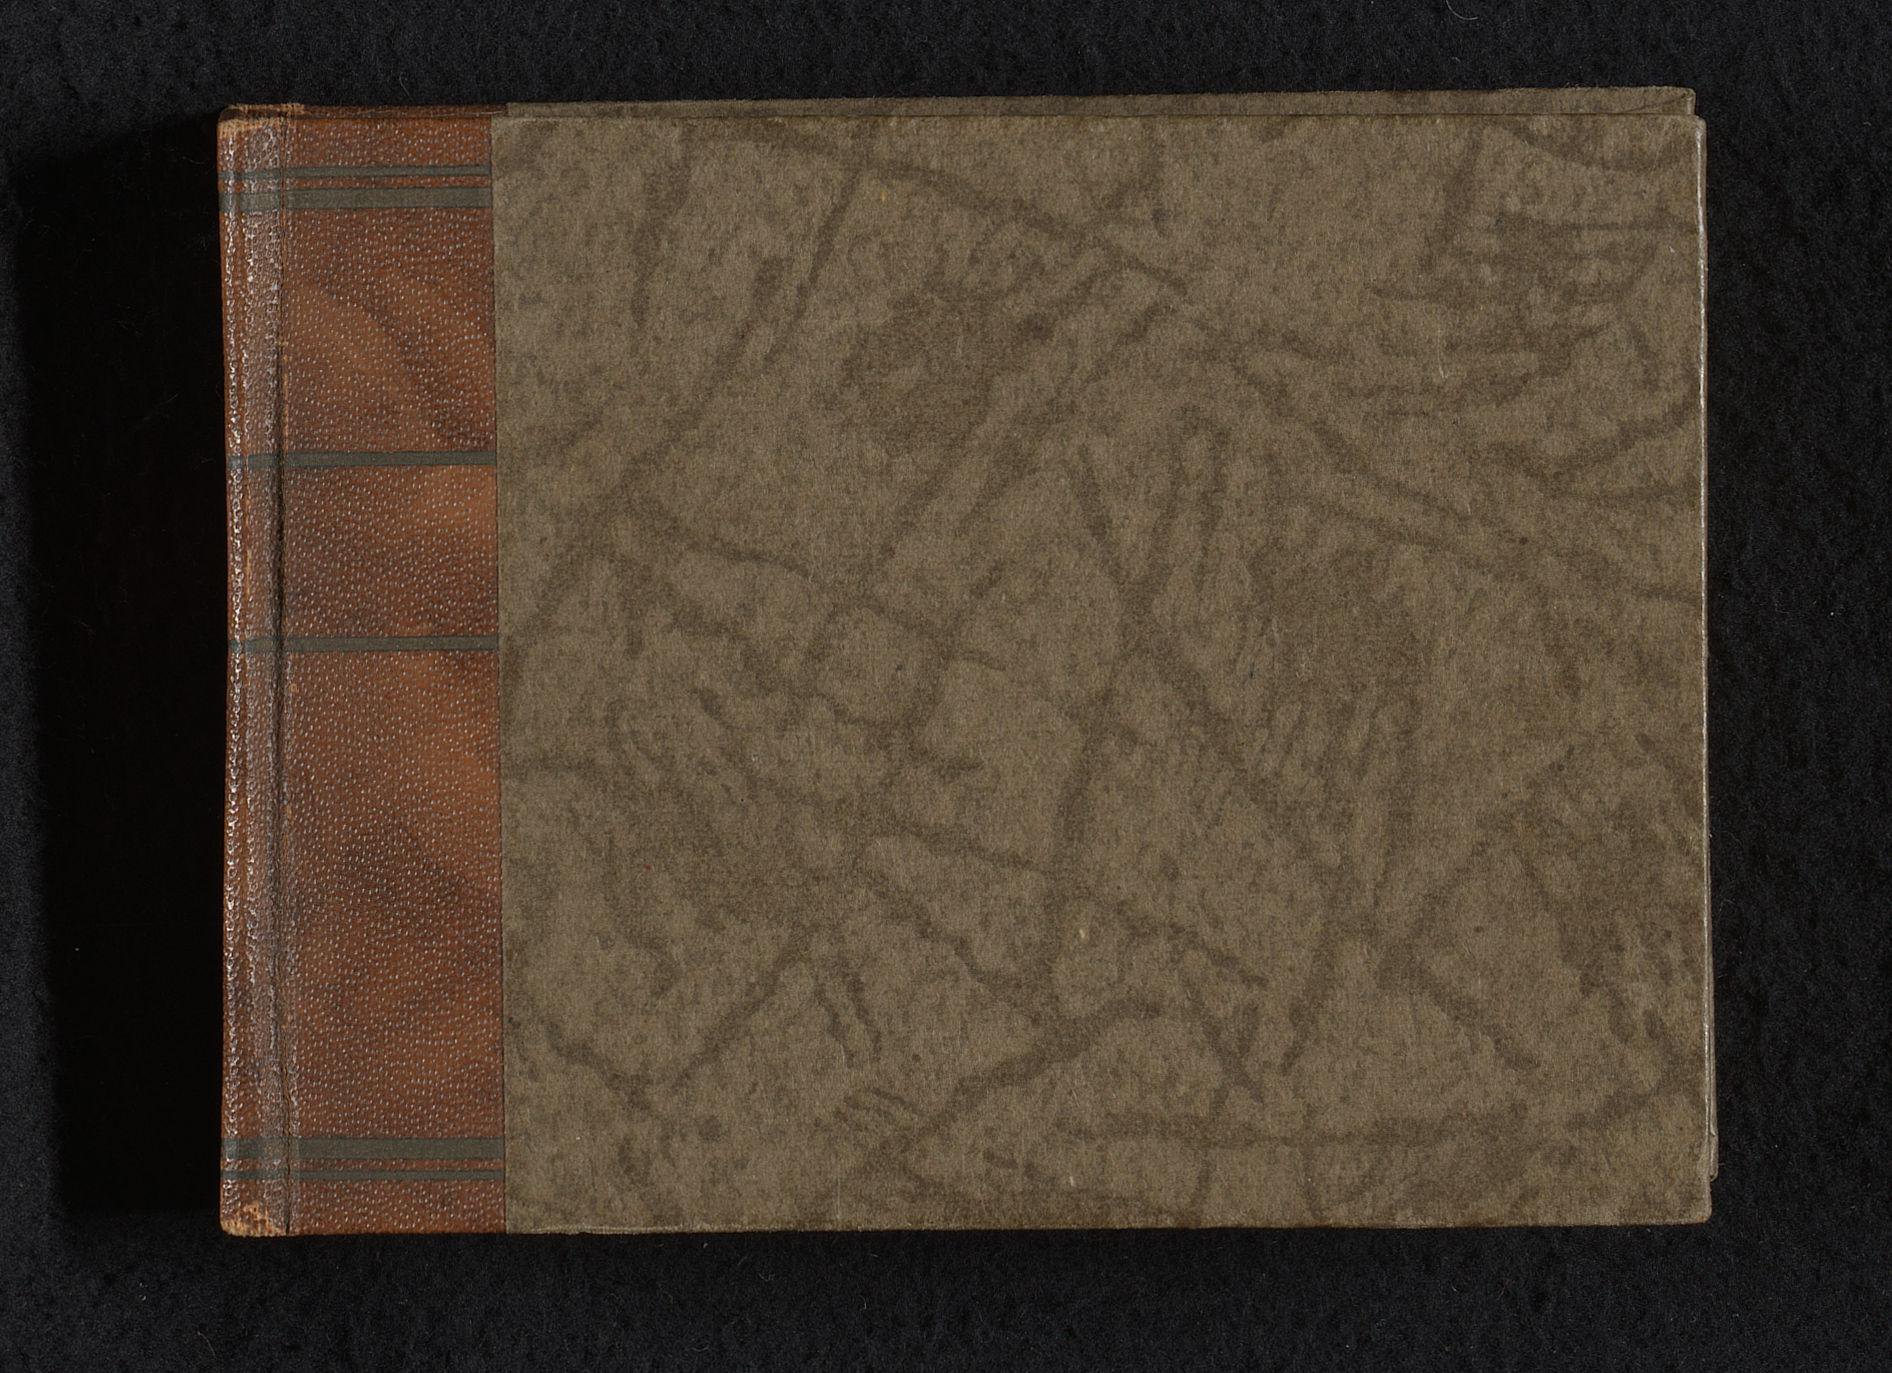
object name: photograph album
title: Mensen uit de omgeving van Norbert van den Berg (1901-1972) thuis en tijdens uitjes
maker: norbert van den berg (1901-1972)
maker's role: amateurfotograaf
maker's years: 1901-1972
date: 1935-1950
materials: paper, cardboard, leather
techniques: gelatin silver print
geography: netherlands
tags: family life at home, outing, pleasure trip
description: Insteekalbum met 51 foto's van de familie Van den Berg thuis en tijdens uitjes.